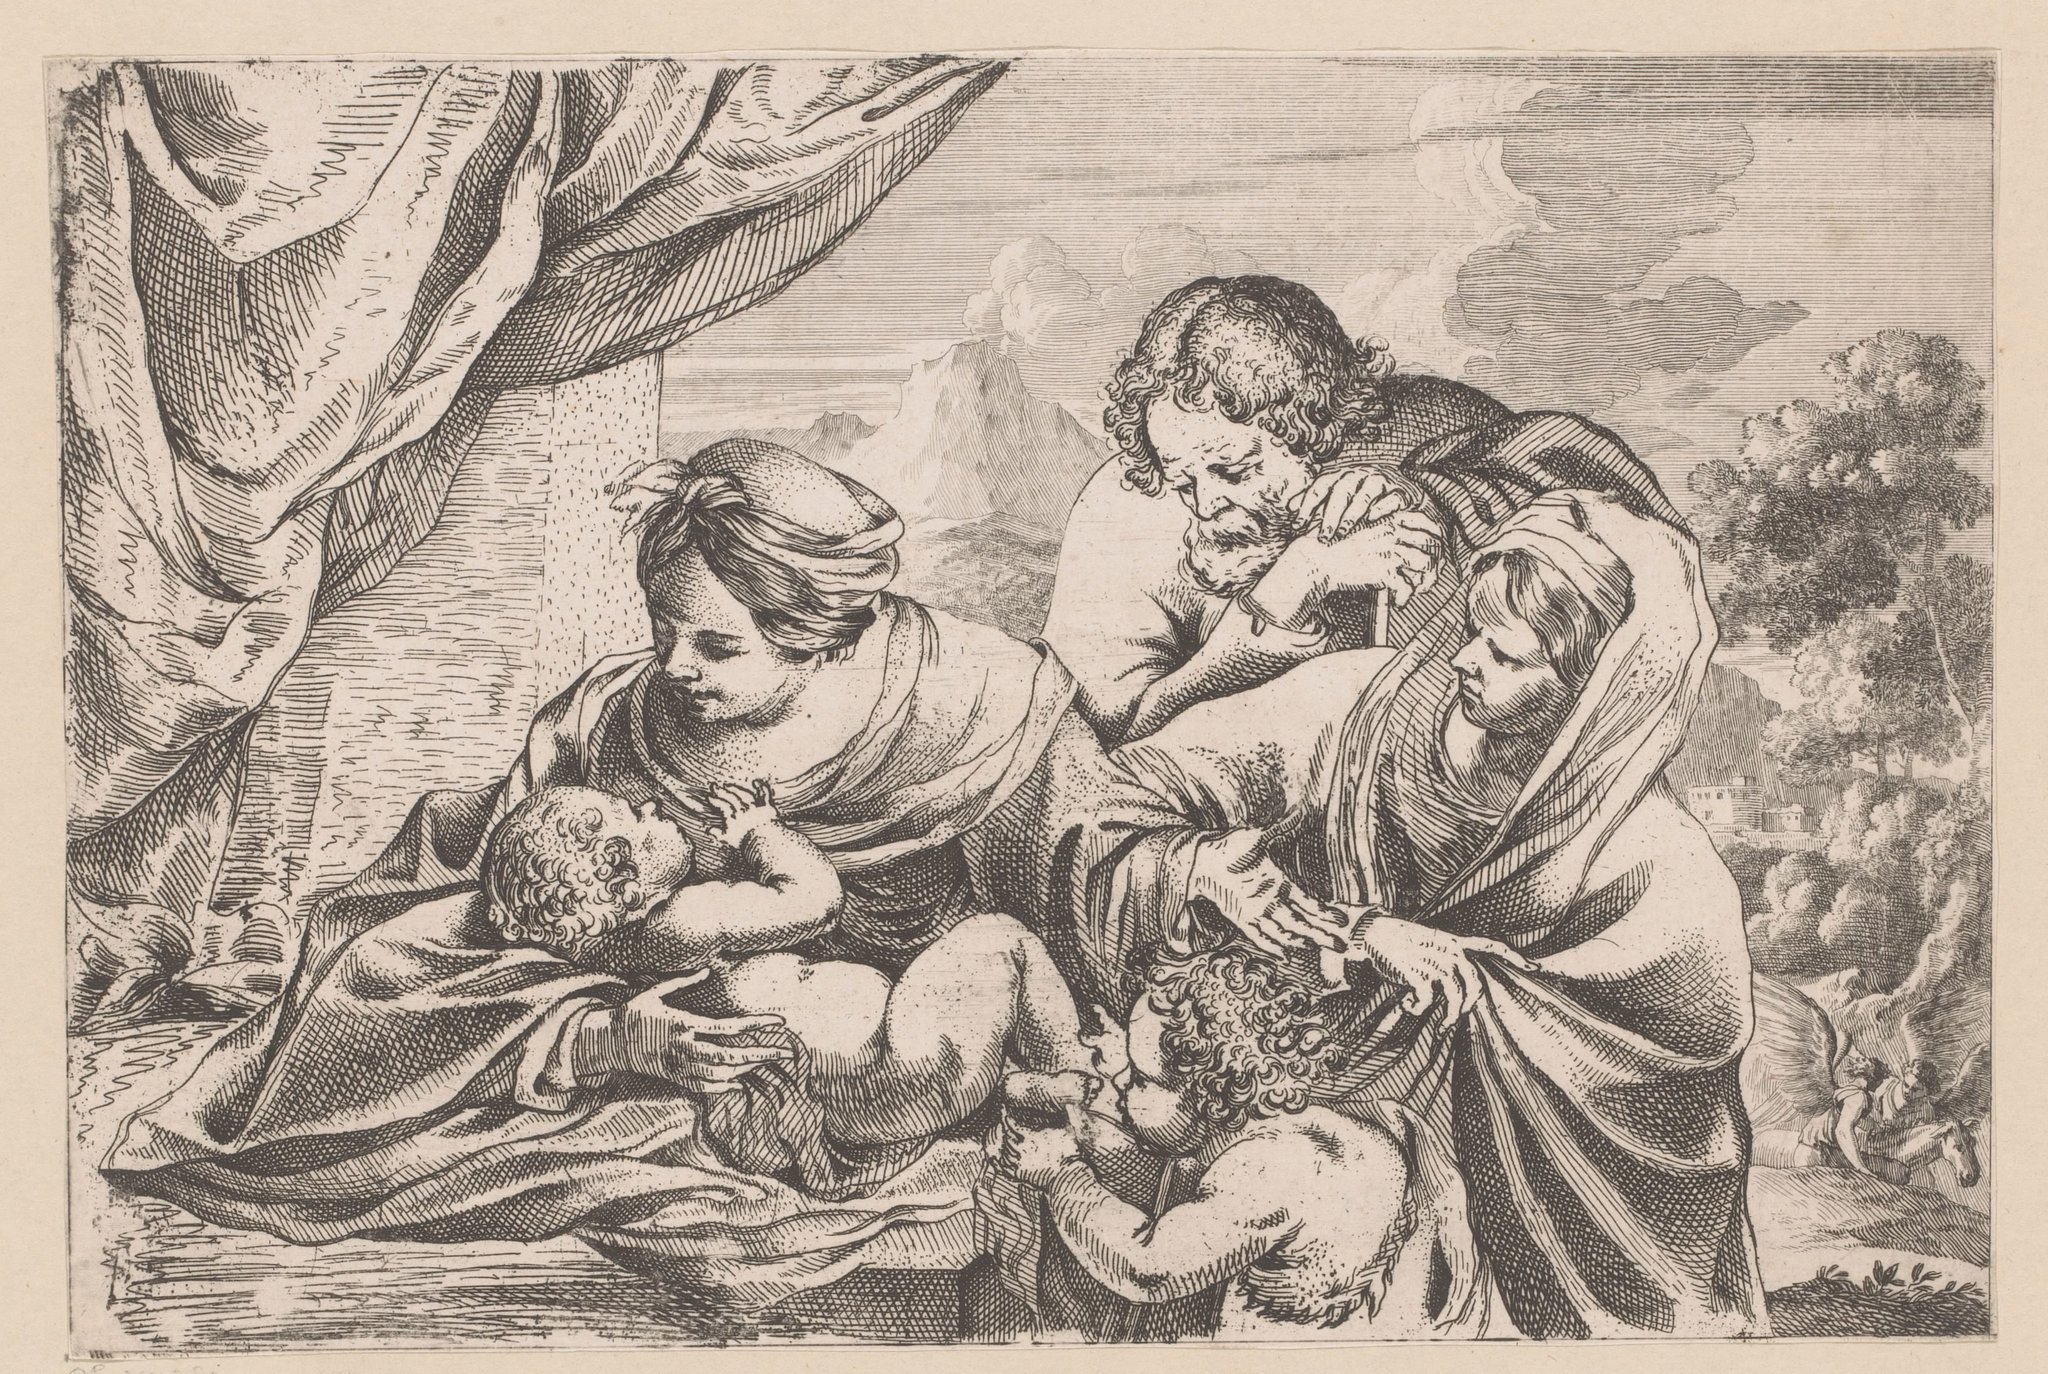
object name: print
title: Heilige Familie met Johannes en Elisabeth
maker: Anonymous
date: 1600-1650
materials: paper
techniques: etching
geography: france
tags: holy family with john the baptist, elisabeth present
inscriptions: collector's mark: Lugt 240